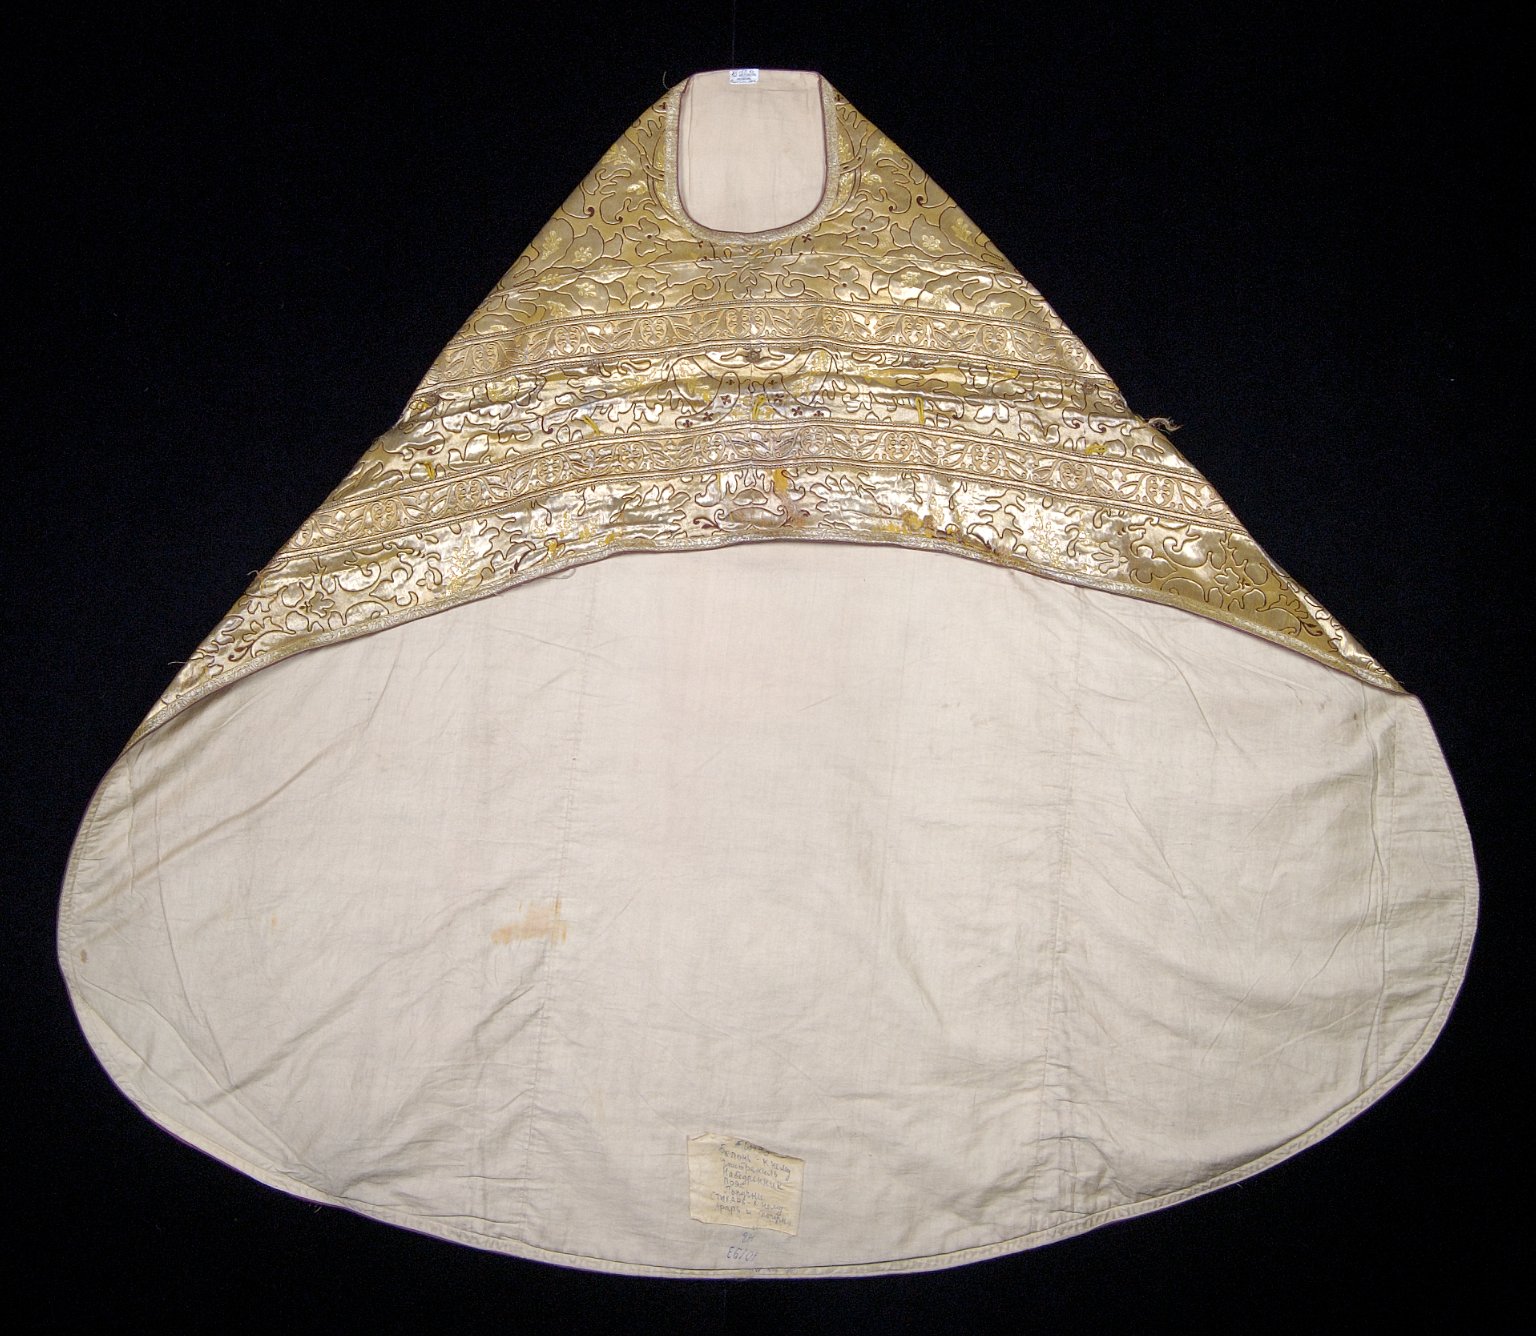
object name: ensemble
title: Set of vestments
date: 1876-1900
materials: cotton, silk